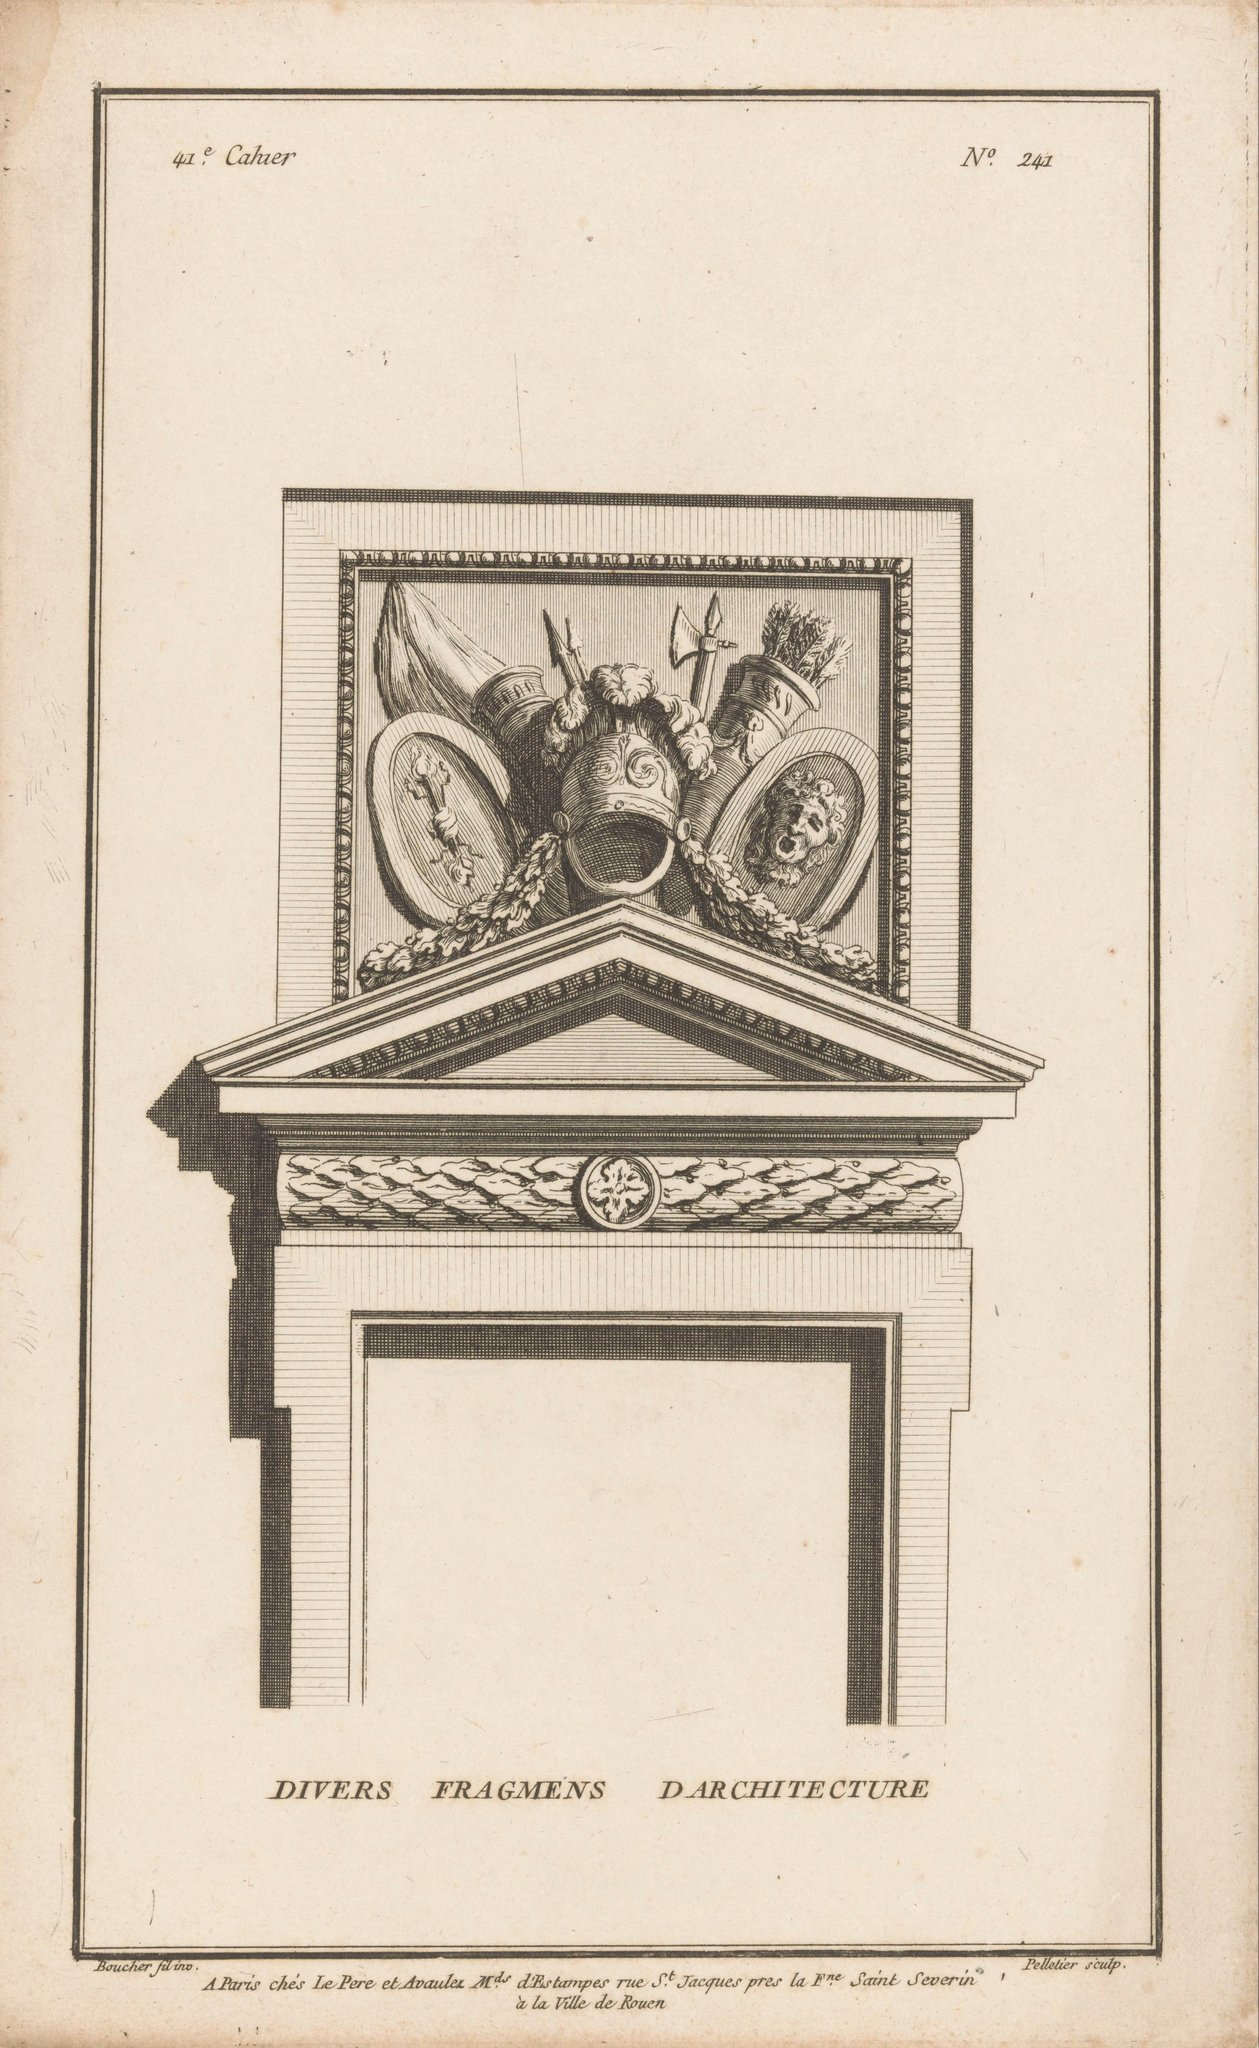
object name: ornament print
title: Paneel met wapens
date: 1772-1779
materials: paper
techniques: engraving, etching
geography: paris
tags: helmet, protective weapons: shield, other architectural details (with name), weapons, door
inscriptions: collector's mark: Lugt 2760, collector's mark: Lugt 2228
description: Een paneel met een helm, schilden en wapens boven een deur- of raamopening met een driehoekig fronton. Prentnummer 241.